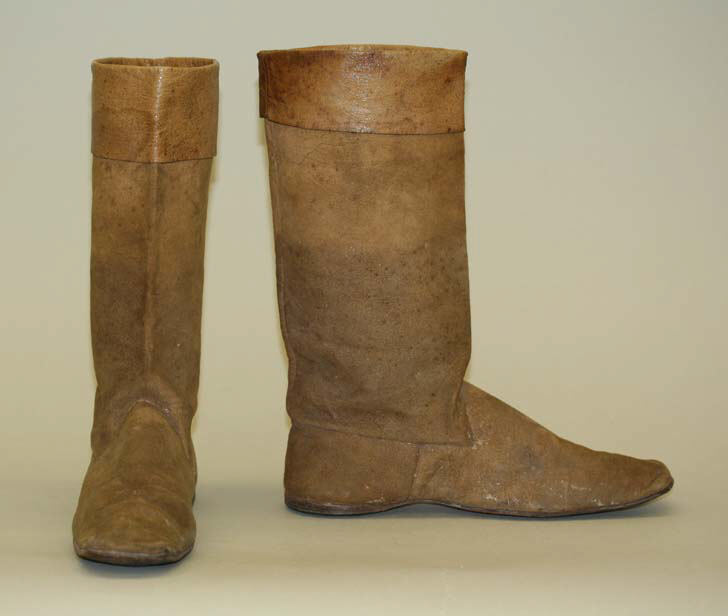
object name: boot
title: Boots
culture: british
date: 1830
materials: leather